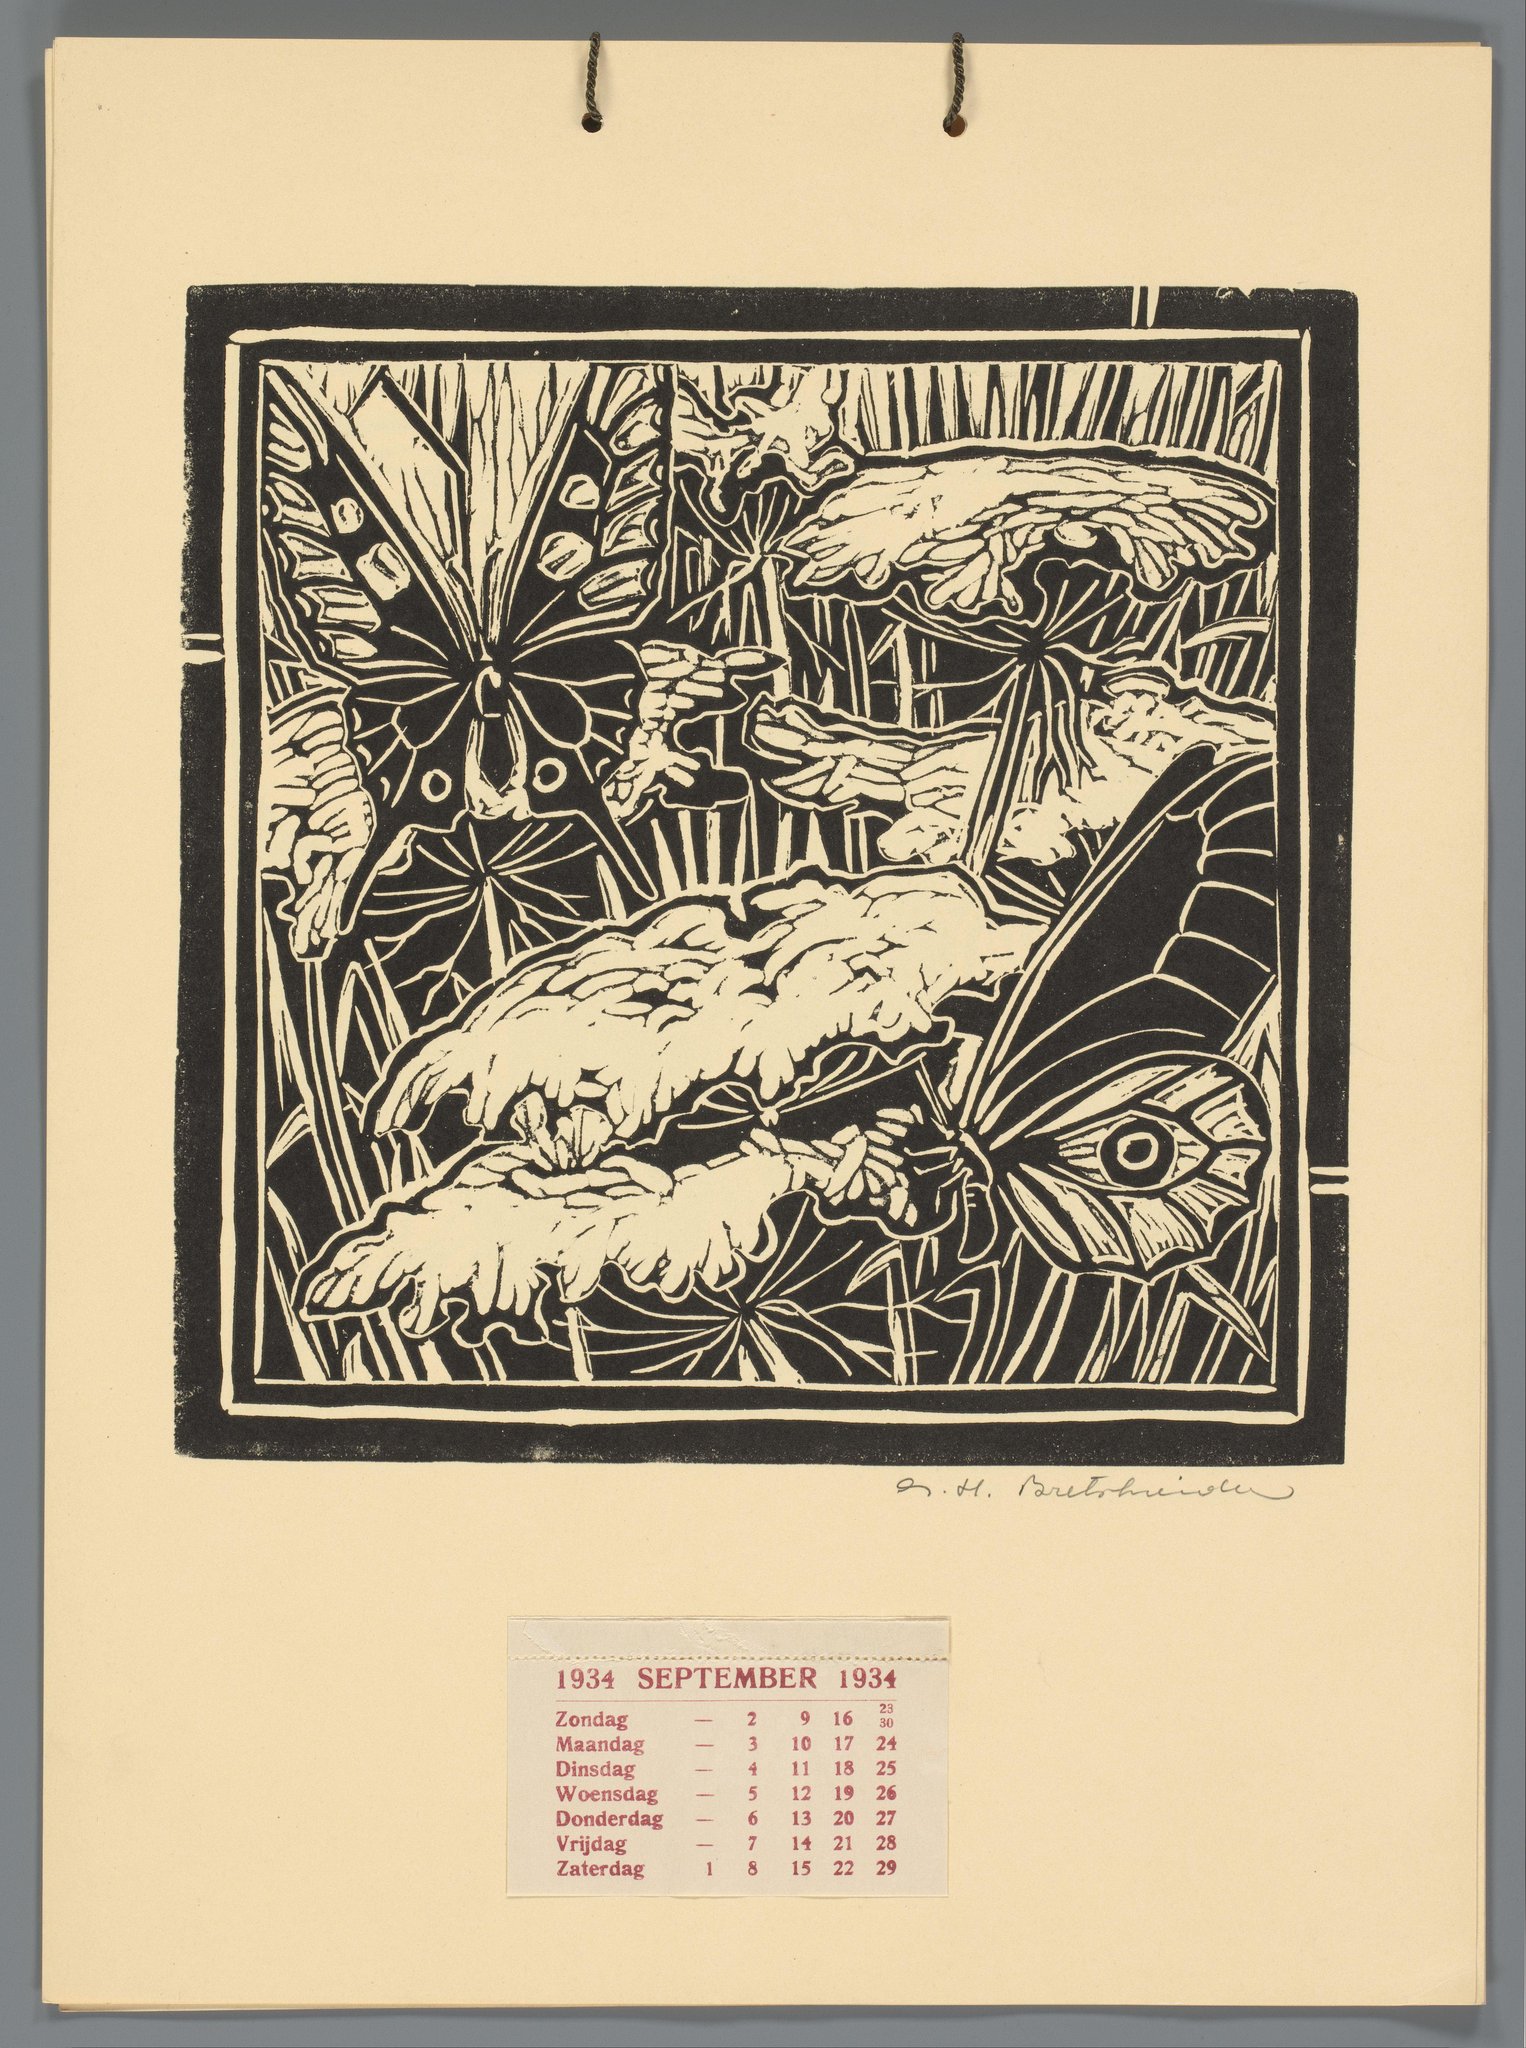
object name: print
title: Kalenderblad voor september 1934 met vlinders op bloemen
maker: g.h. bretschneider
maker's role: print maker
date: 1933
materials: paper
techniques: linocut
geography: utrecht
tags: calendar, almanac, insects: butterfly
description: Bij gebrek aan gegevens over de vervaardiger is voor de bepaling van de rechten van dit object gebruik gemaakt van de vervaardigingsdatum.